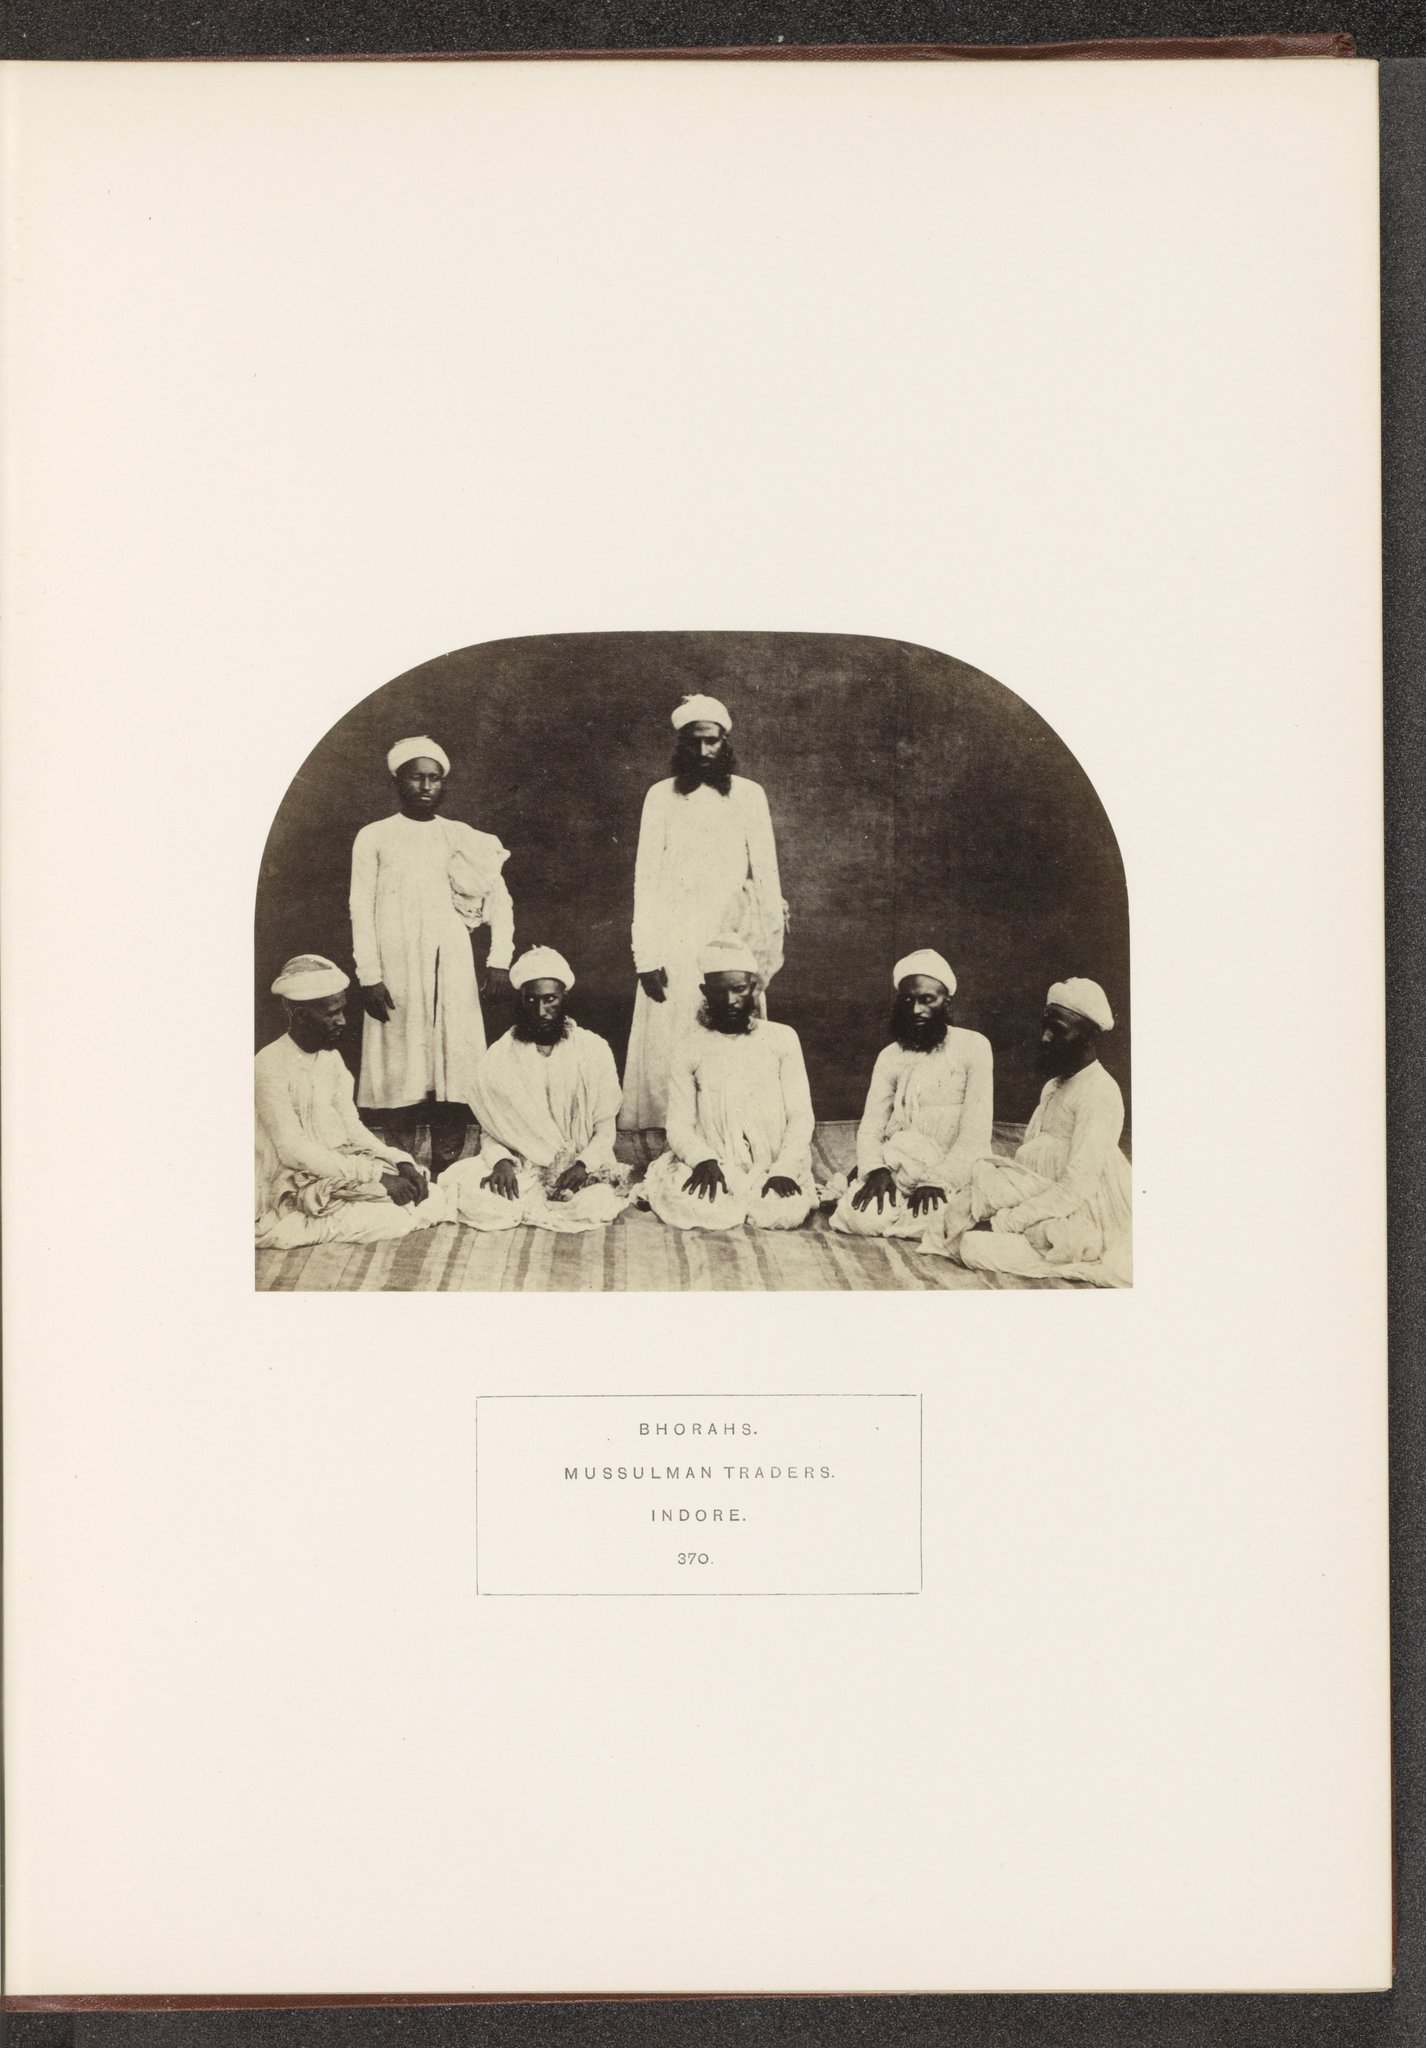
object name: photograph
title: Portrait of seven unknown traders from the Bohra community of Indore, Madhya Pradesh, India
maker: james john waterhouse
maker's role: fotograaf, luitenant, officier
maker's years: 1842-1928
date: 1862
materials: photographic support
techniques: albumen print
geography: indore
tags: human races; peoples; nationalities, merchant, salesman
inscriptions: inscription: ‘BHORAHS./ MUSSULMAN TRADERS./ INDORE.’, number: ‘370.’